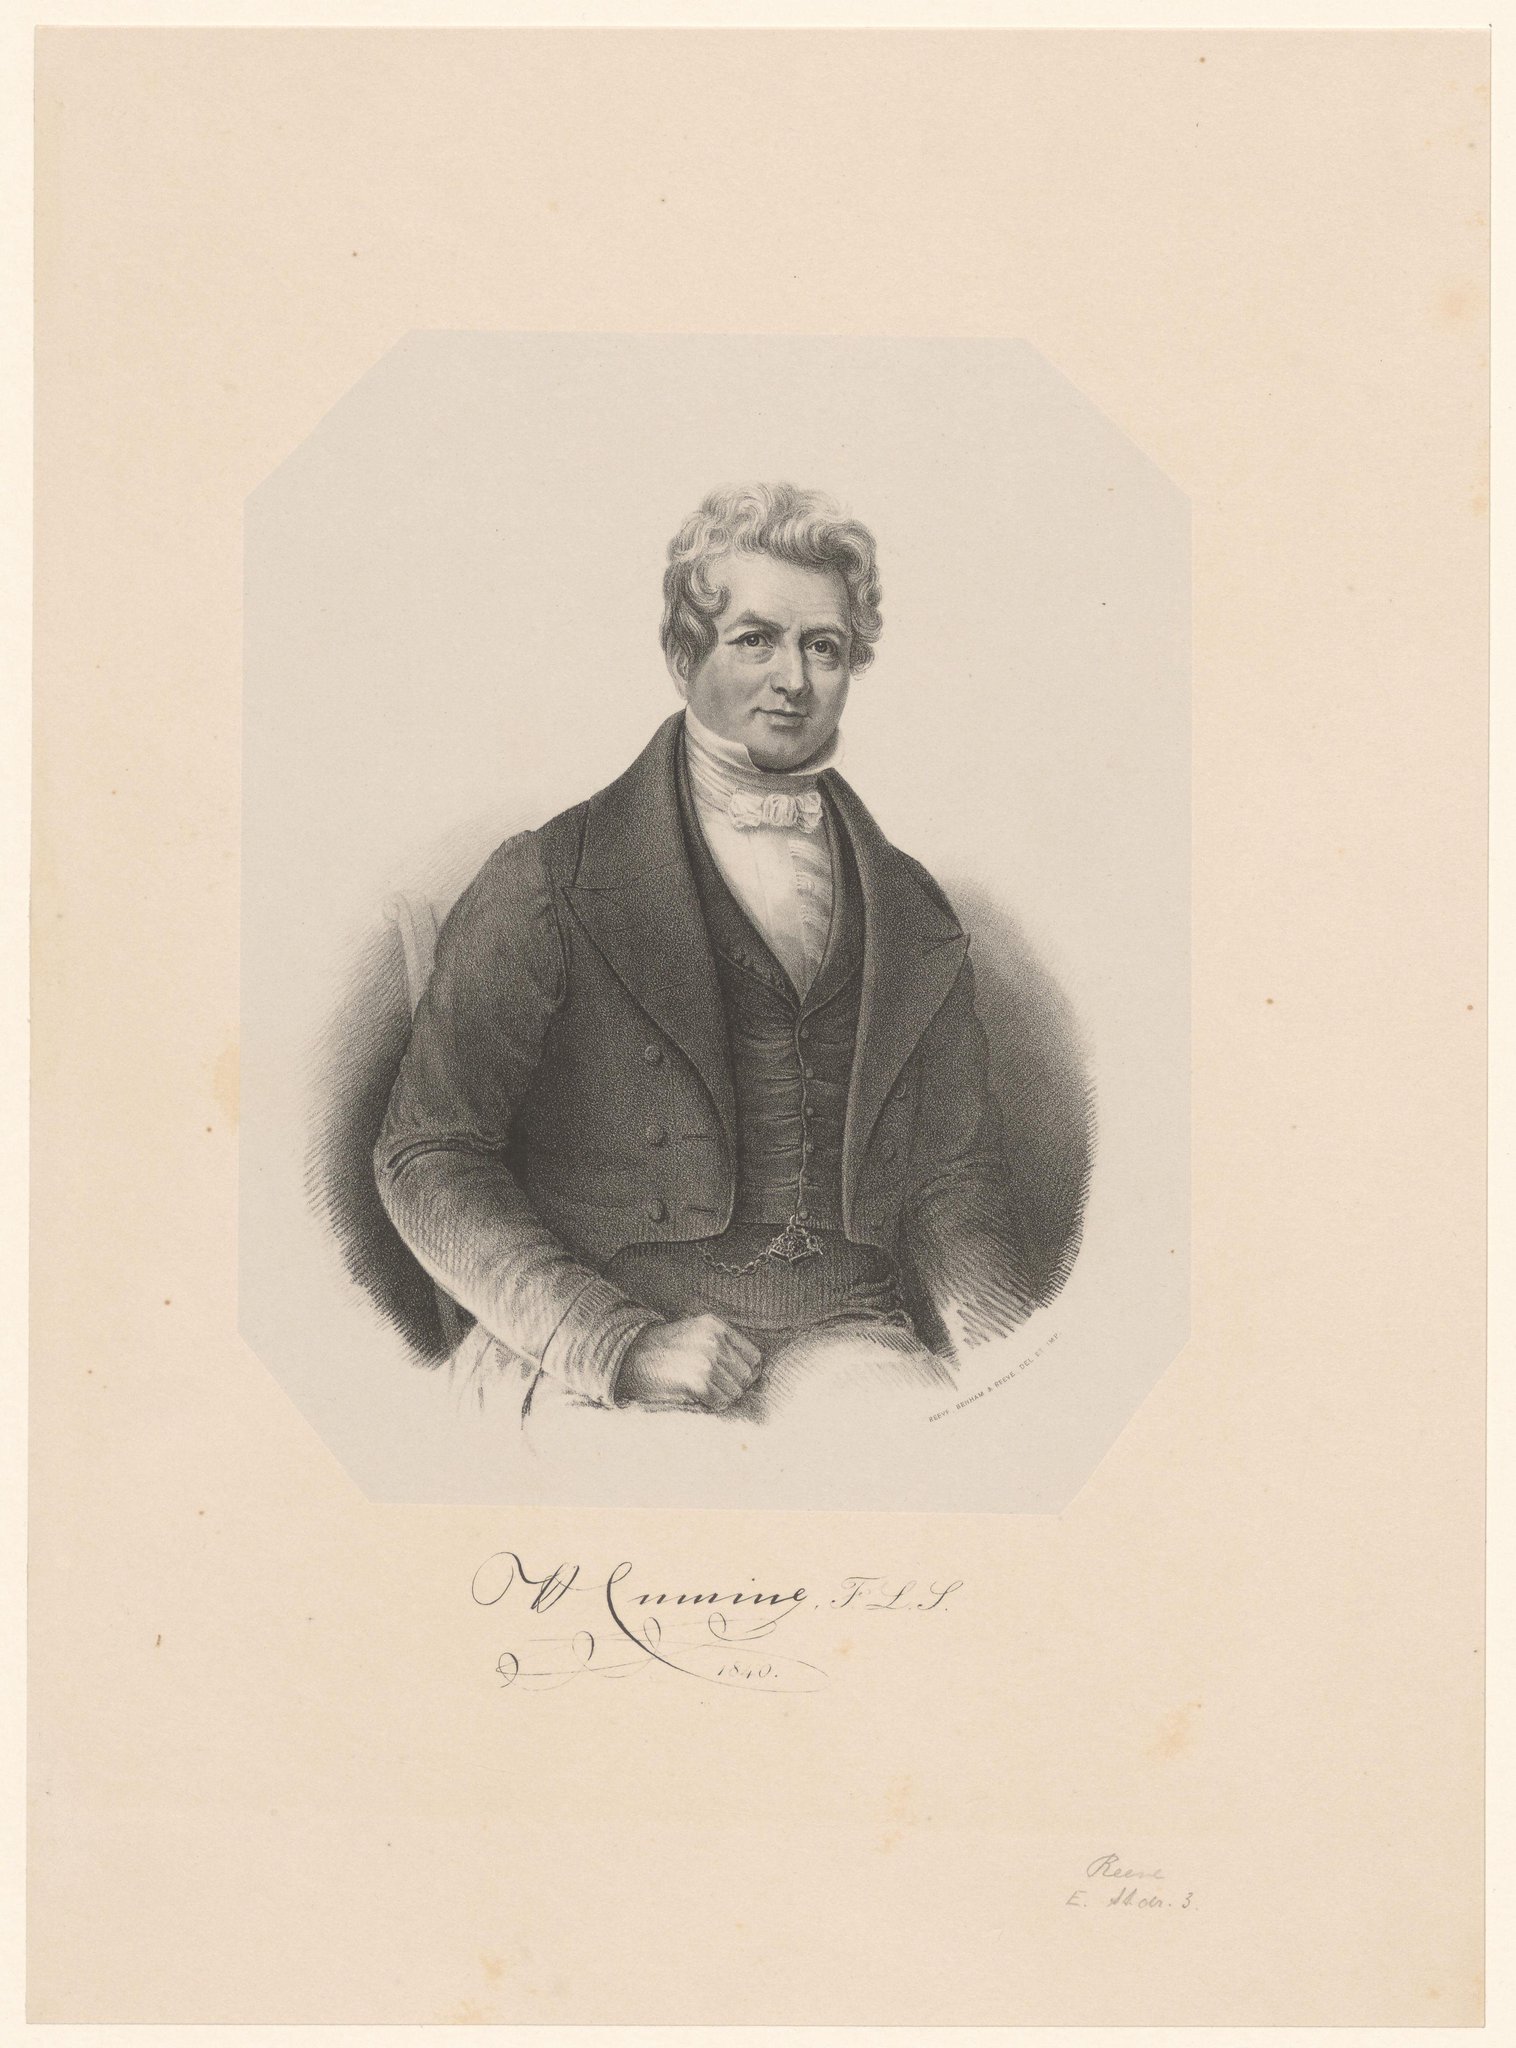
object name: print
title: Portret van Hugh Cuming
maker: reeve en benham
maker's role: print maker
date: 1840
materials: paper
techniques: lithograph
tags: adult man, historical persons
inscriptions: collector's mark: Lugt 2228